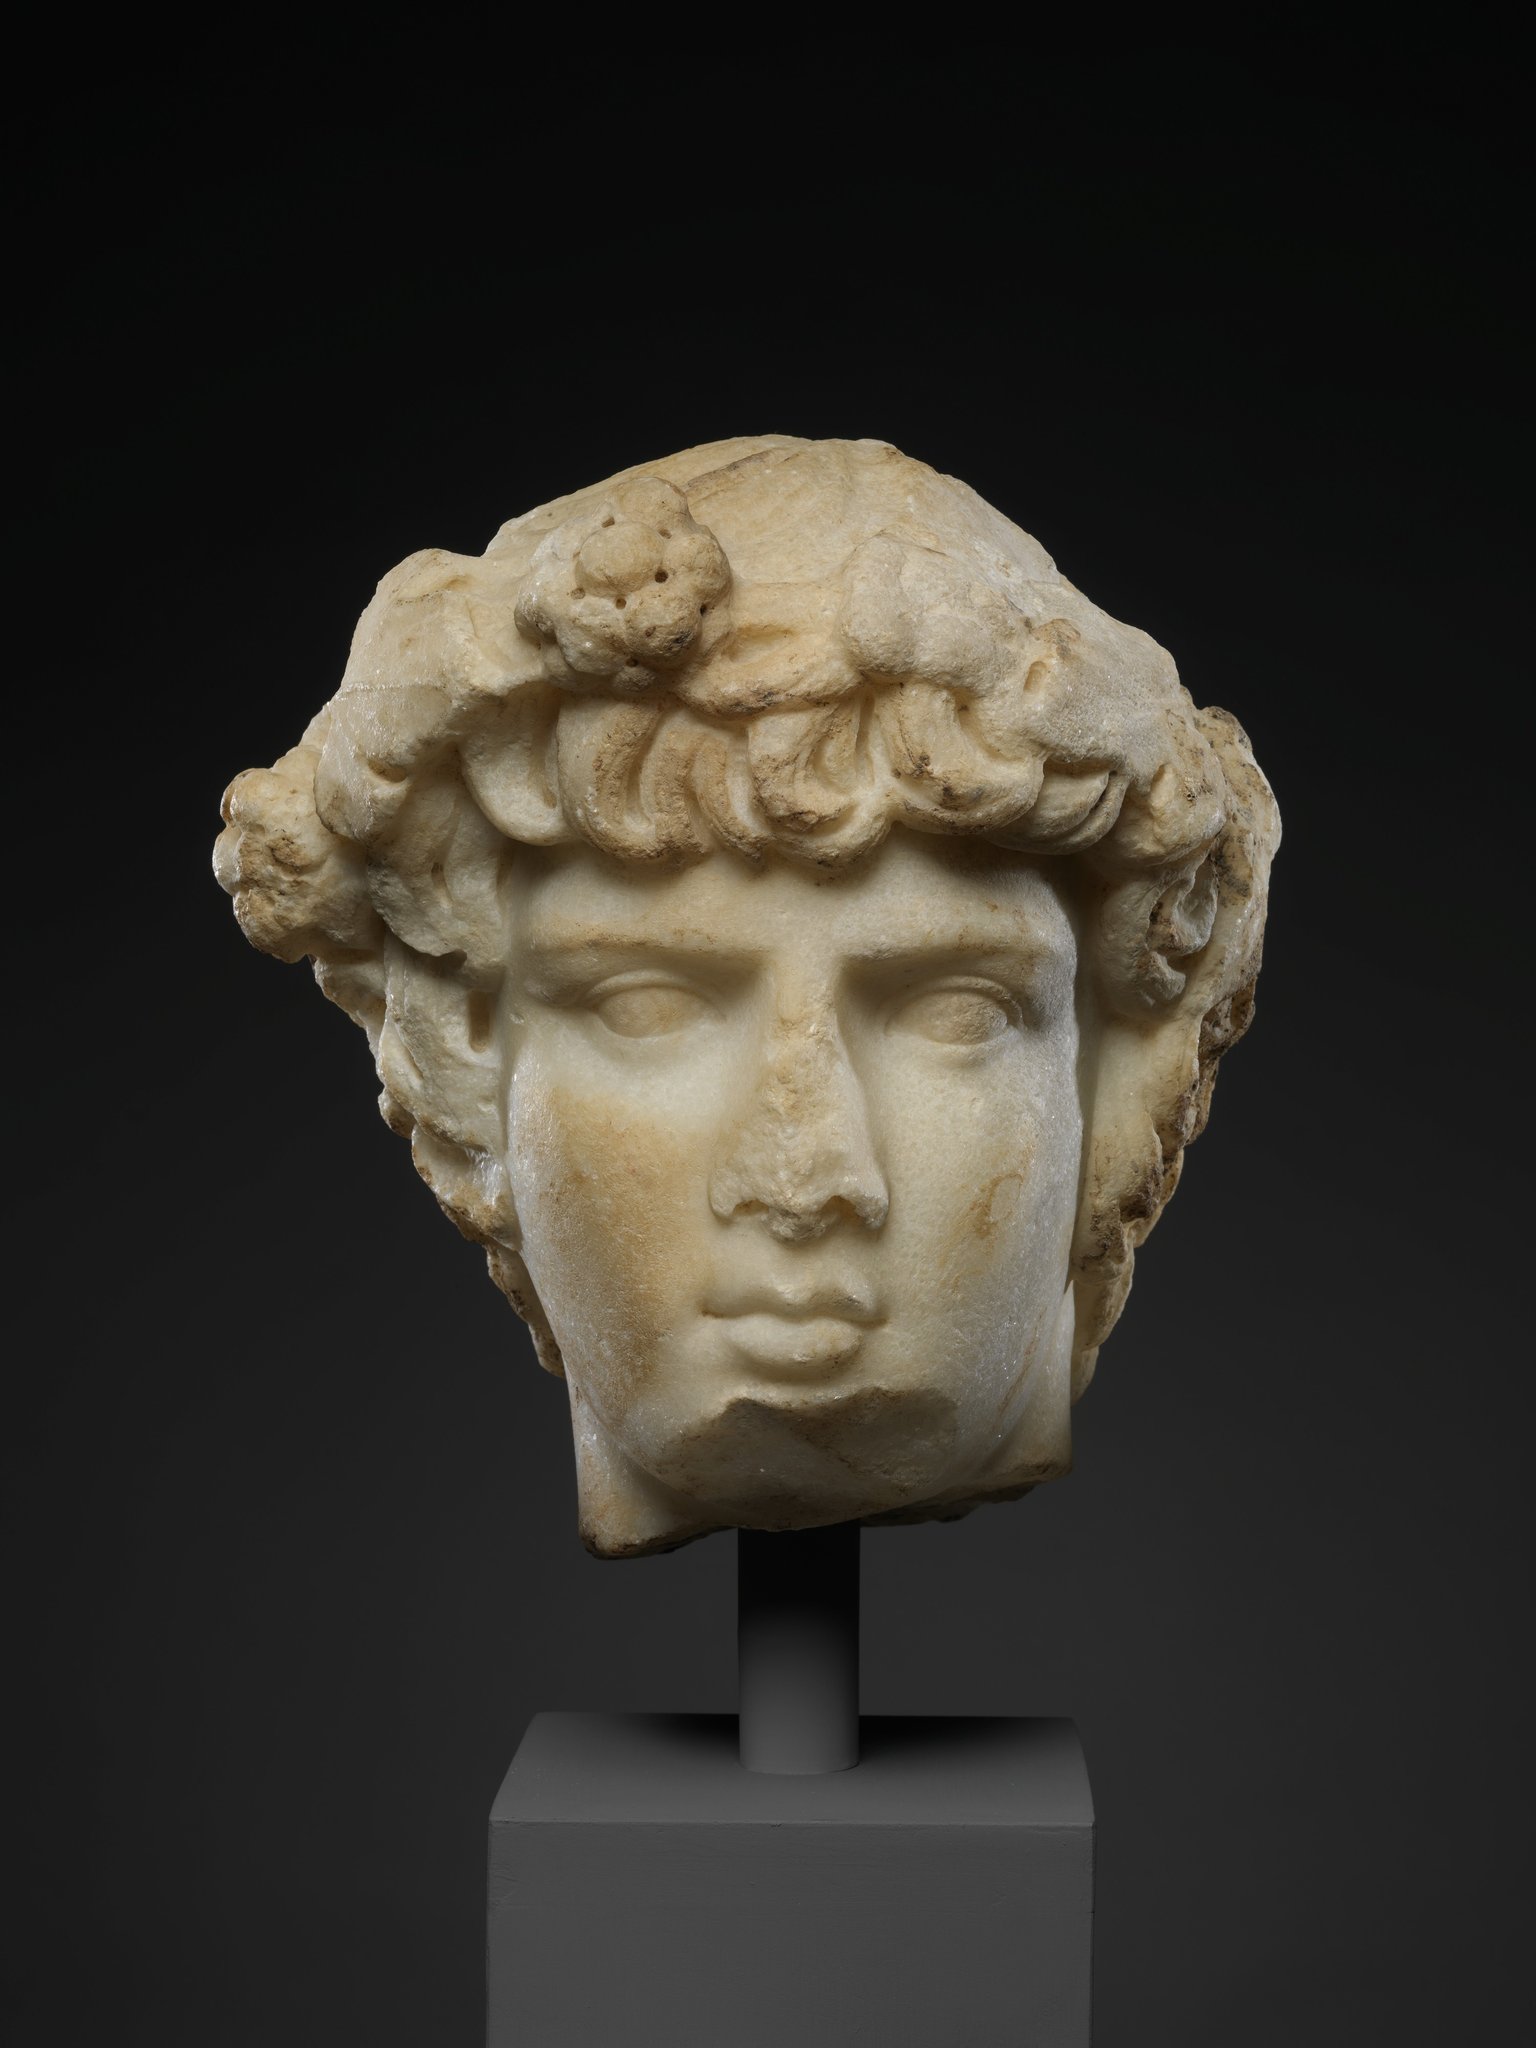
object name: portrait head of antinoos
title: Marble portrait head of Antinoos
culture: roman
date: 130-138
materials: marble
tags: heads,men,portraits